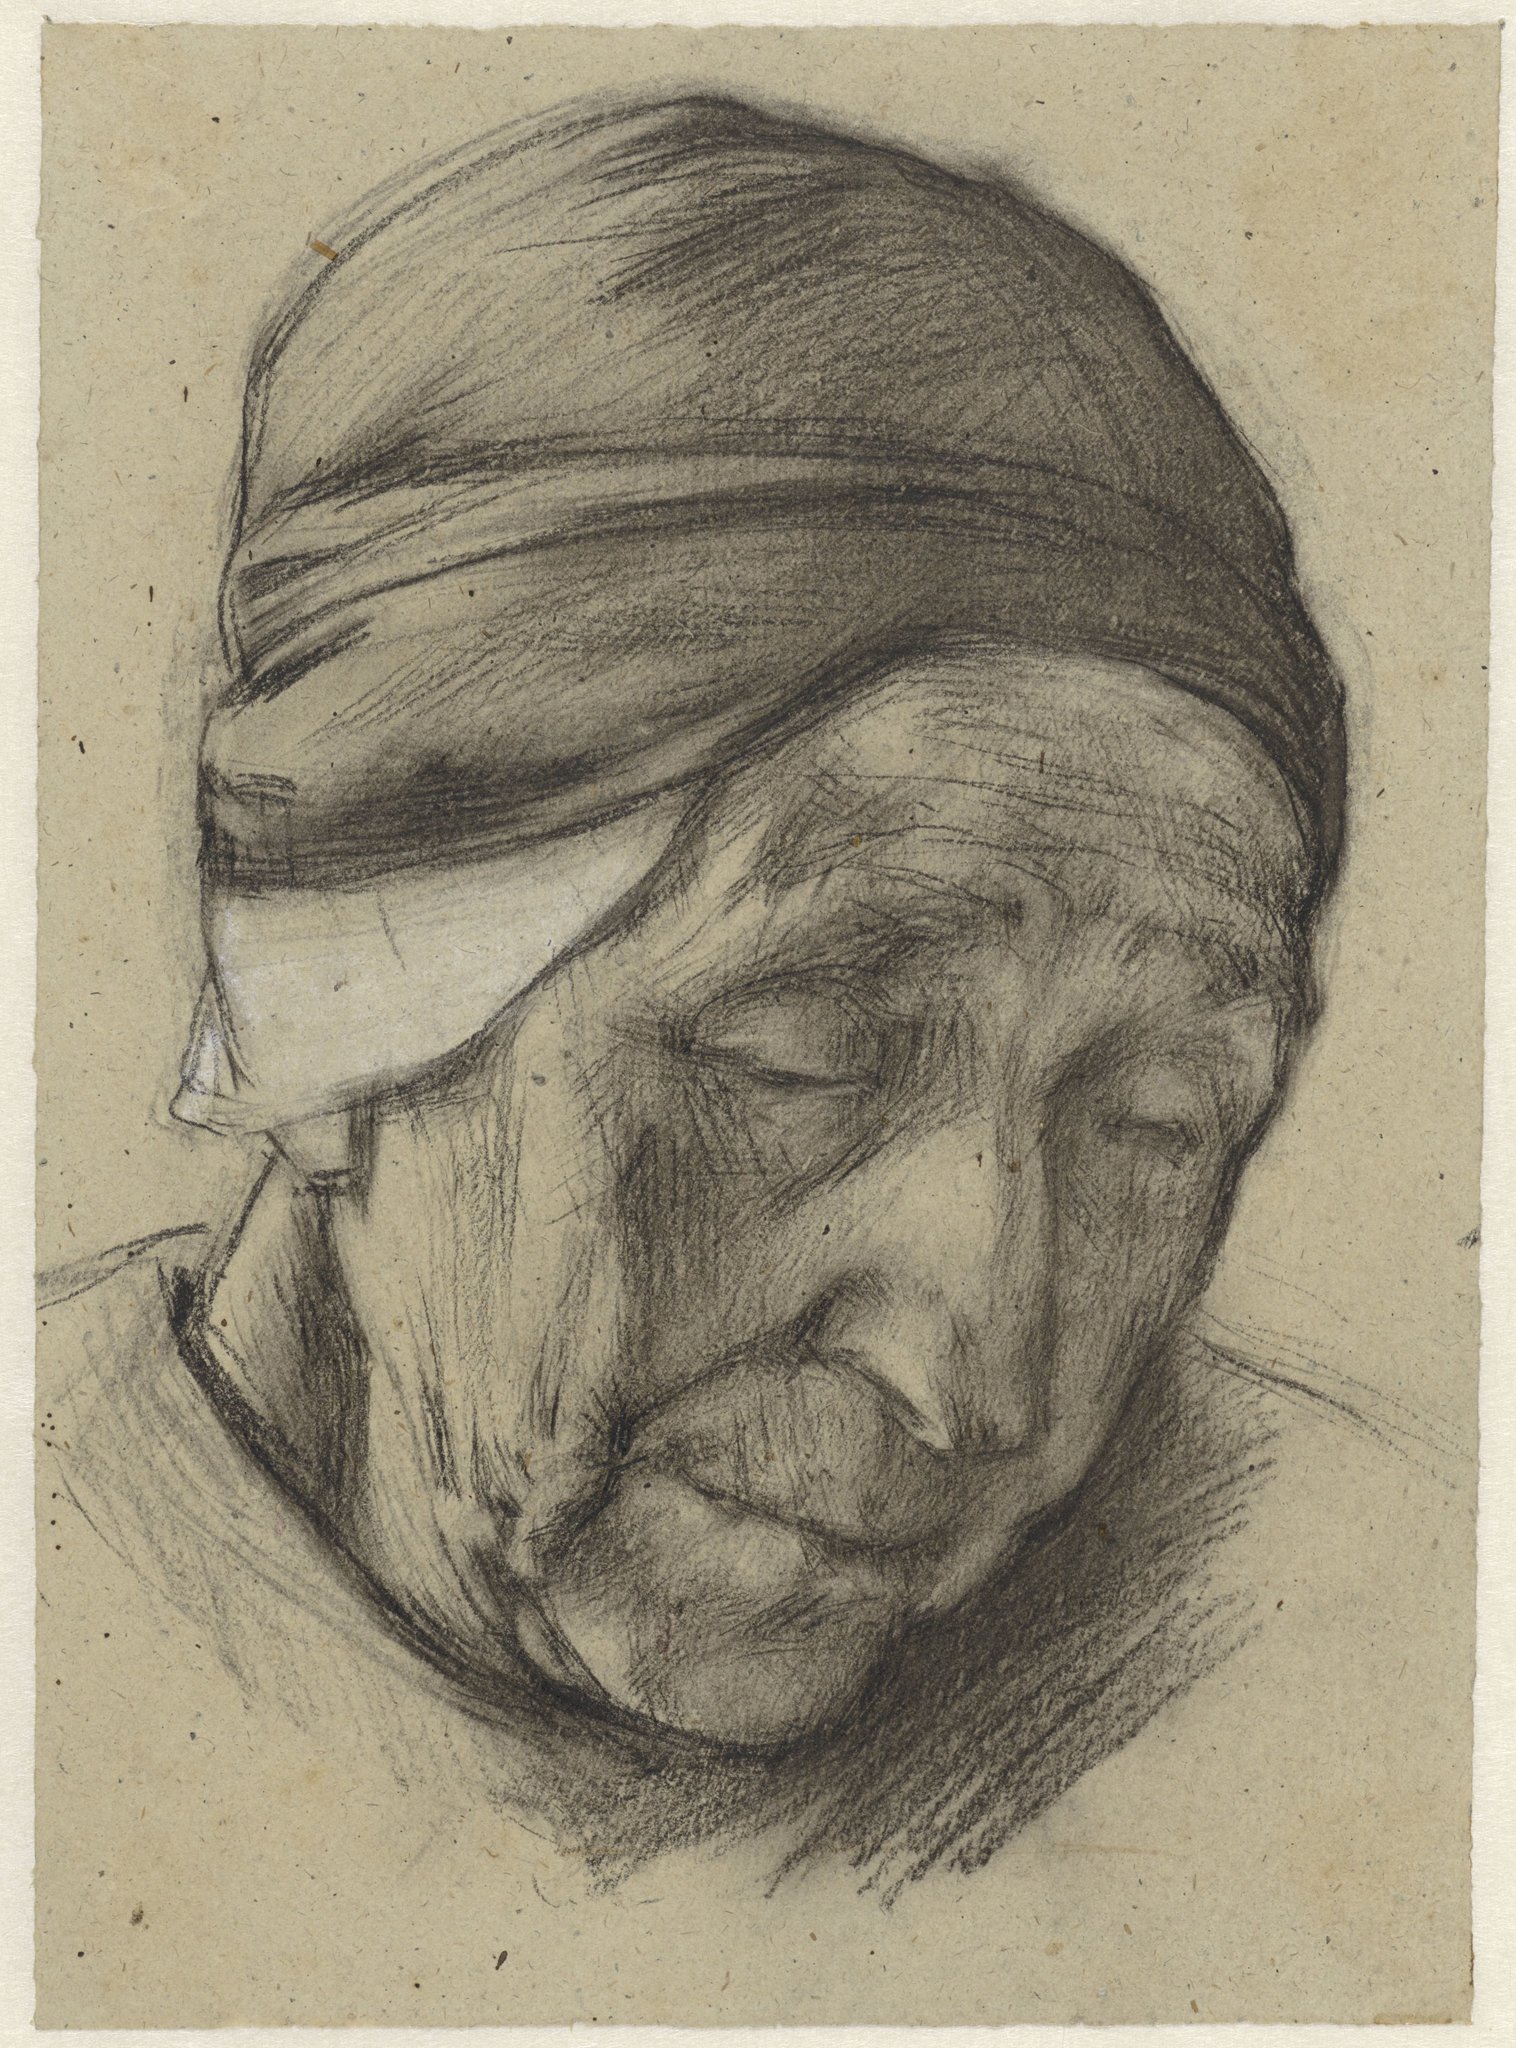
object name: drawing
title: Hoofd van Jantien Klinker, driekwart gezien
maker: anthon gerhard alexander van rappard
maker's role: draughtsman, print maker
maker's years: 1858-1892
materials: charcoal, paper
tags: anonymous historical person portrayed alone, female sex; woman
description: Model geïdentificeerd door: Egbert Brink, Ridder in het armenhuis. Anthon van Rappard in Drenthe, Waardeel, Drents Historisch Tijdschrift 25-1 (2005), pp. 23-28. ook afgebeeld op een schilderij dat in het Van Gogh-museum is: inv. nr. s353; mededeling van Hans Luijten